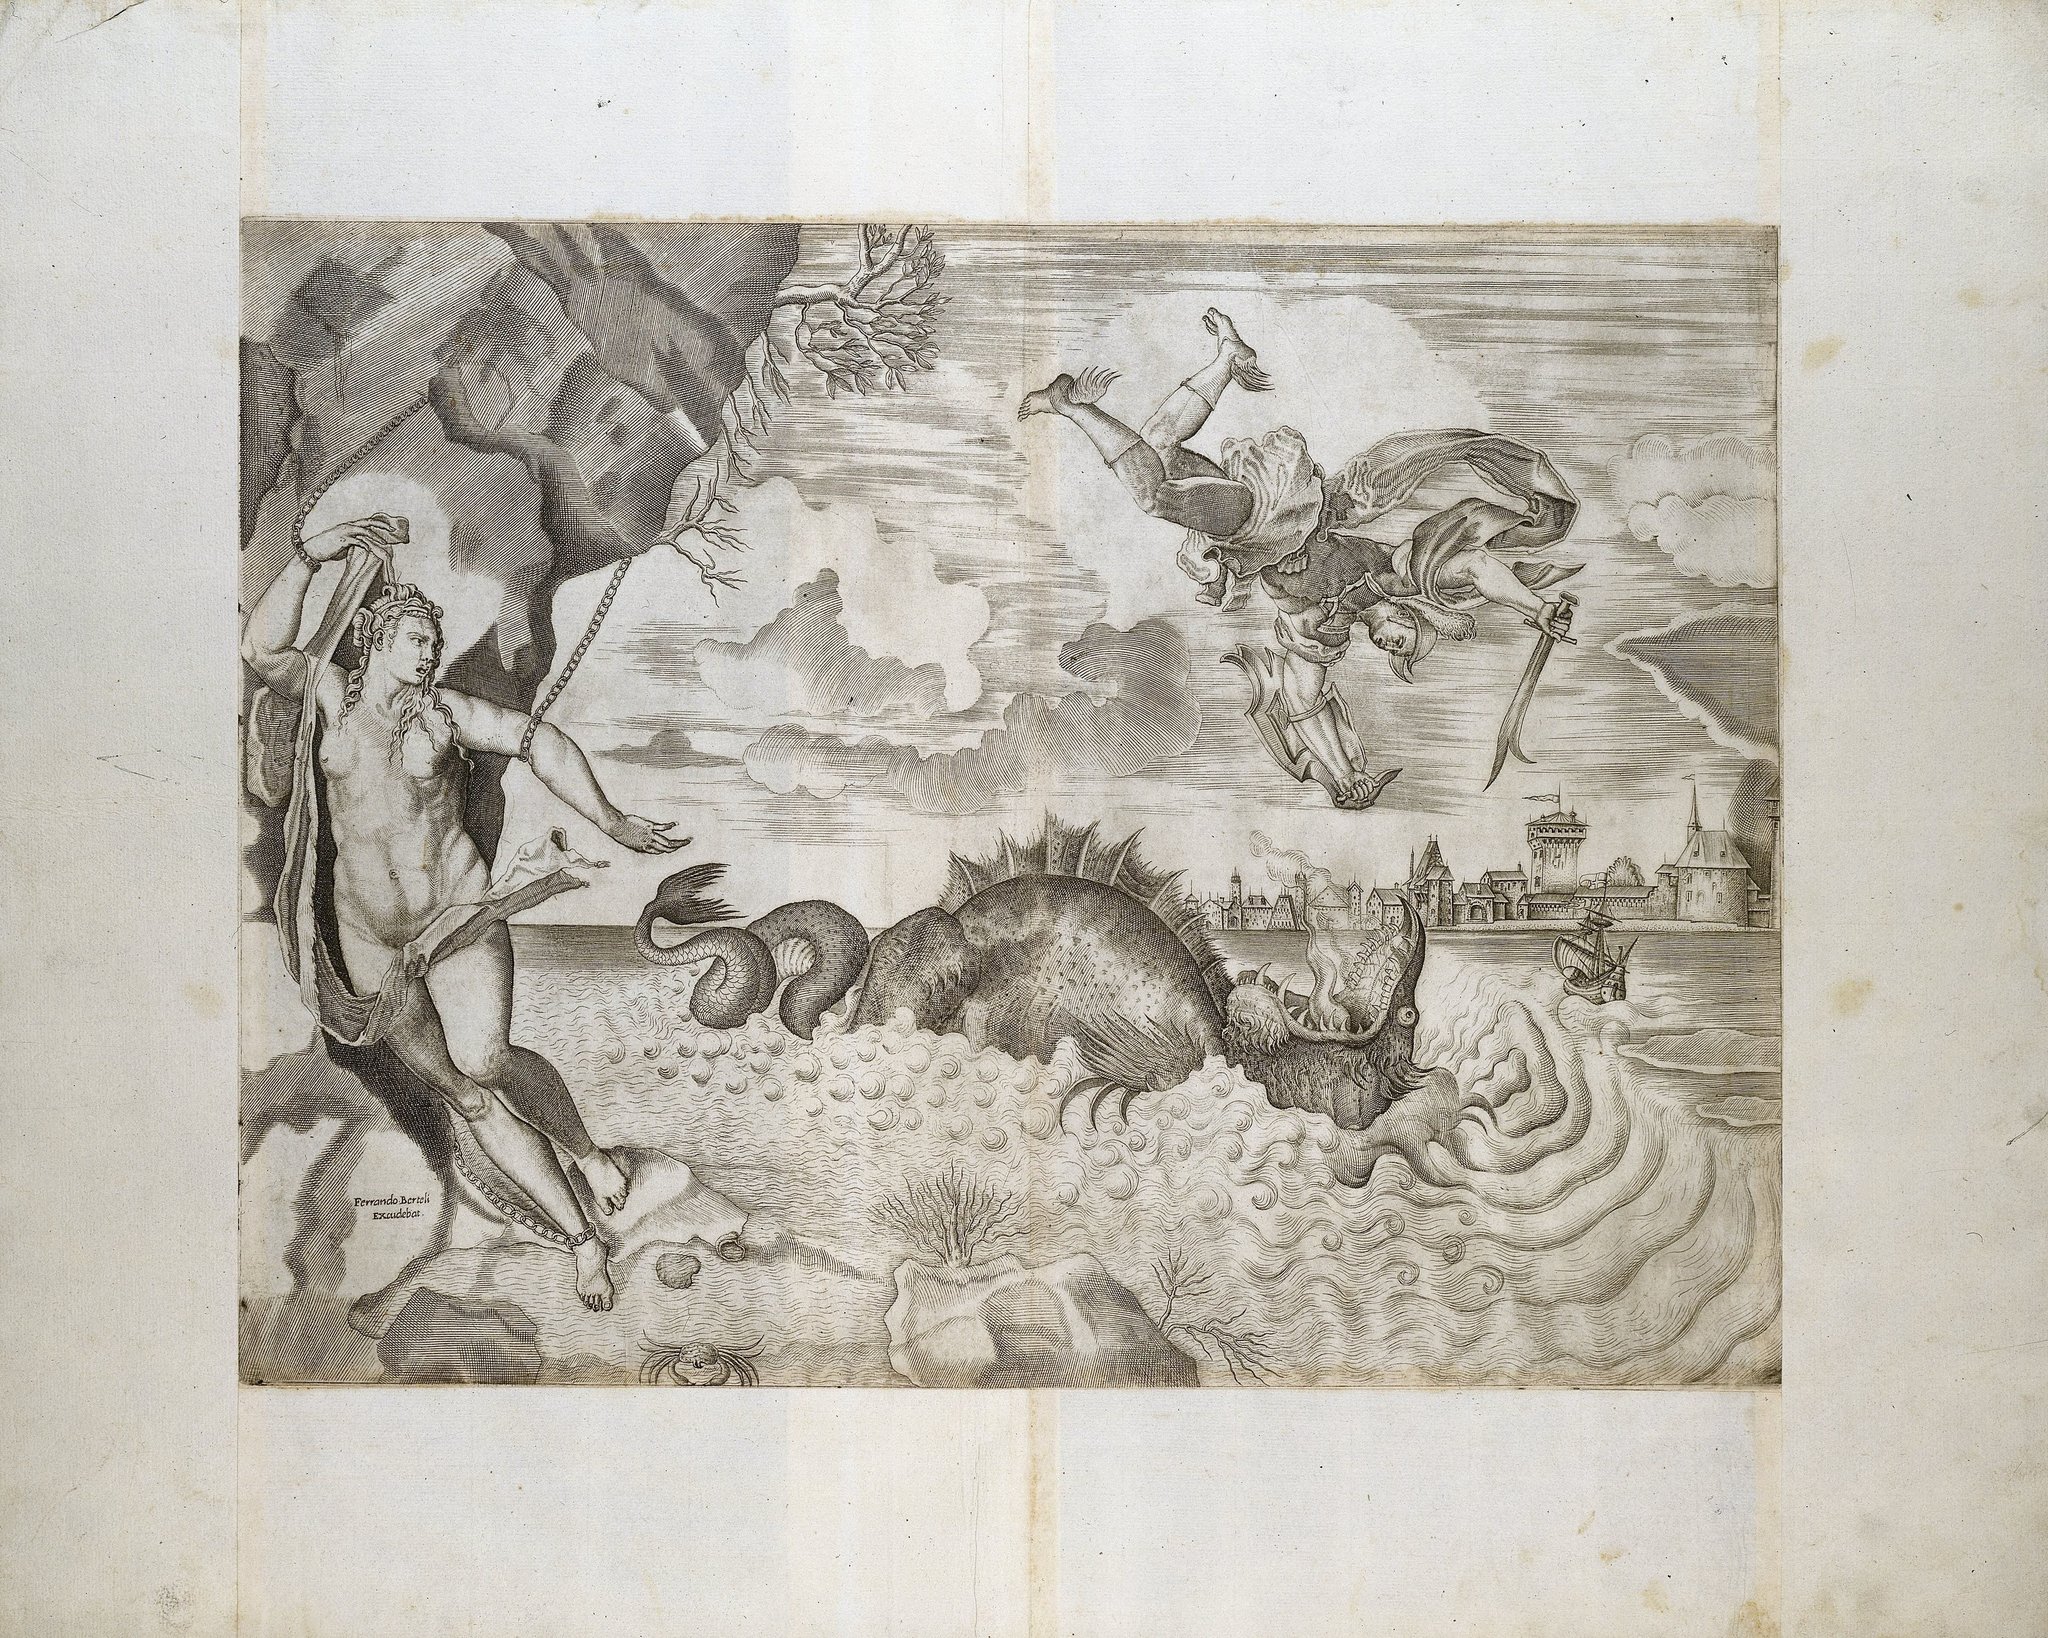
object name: album leaf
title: Perseus and Andromeda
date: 1550-1570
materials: paper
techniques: engraving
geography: italy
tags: perseus and andromeda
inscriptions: collector's mark: Lugt 2228, collector's mark: Lugt 2760, watermark, number: ‘32’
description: Zobel was very partial to the work of Giulio Sanuto. He had at least six prints by this Venetian printmaker in his album, including this large engraving after a design by the famous Venetian painter Titian. We see the nude princess Andromeda chained to a rock, a human sacrifice for a ferocious sea monster. She is rescued by the hero Perseus who flies down, headlong, to attack the creature.